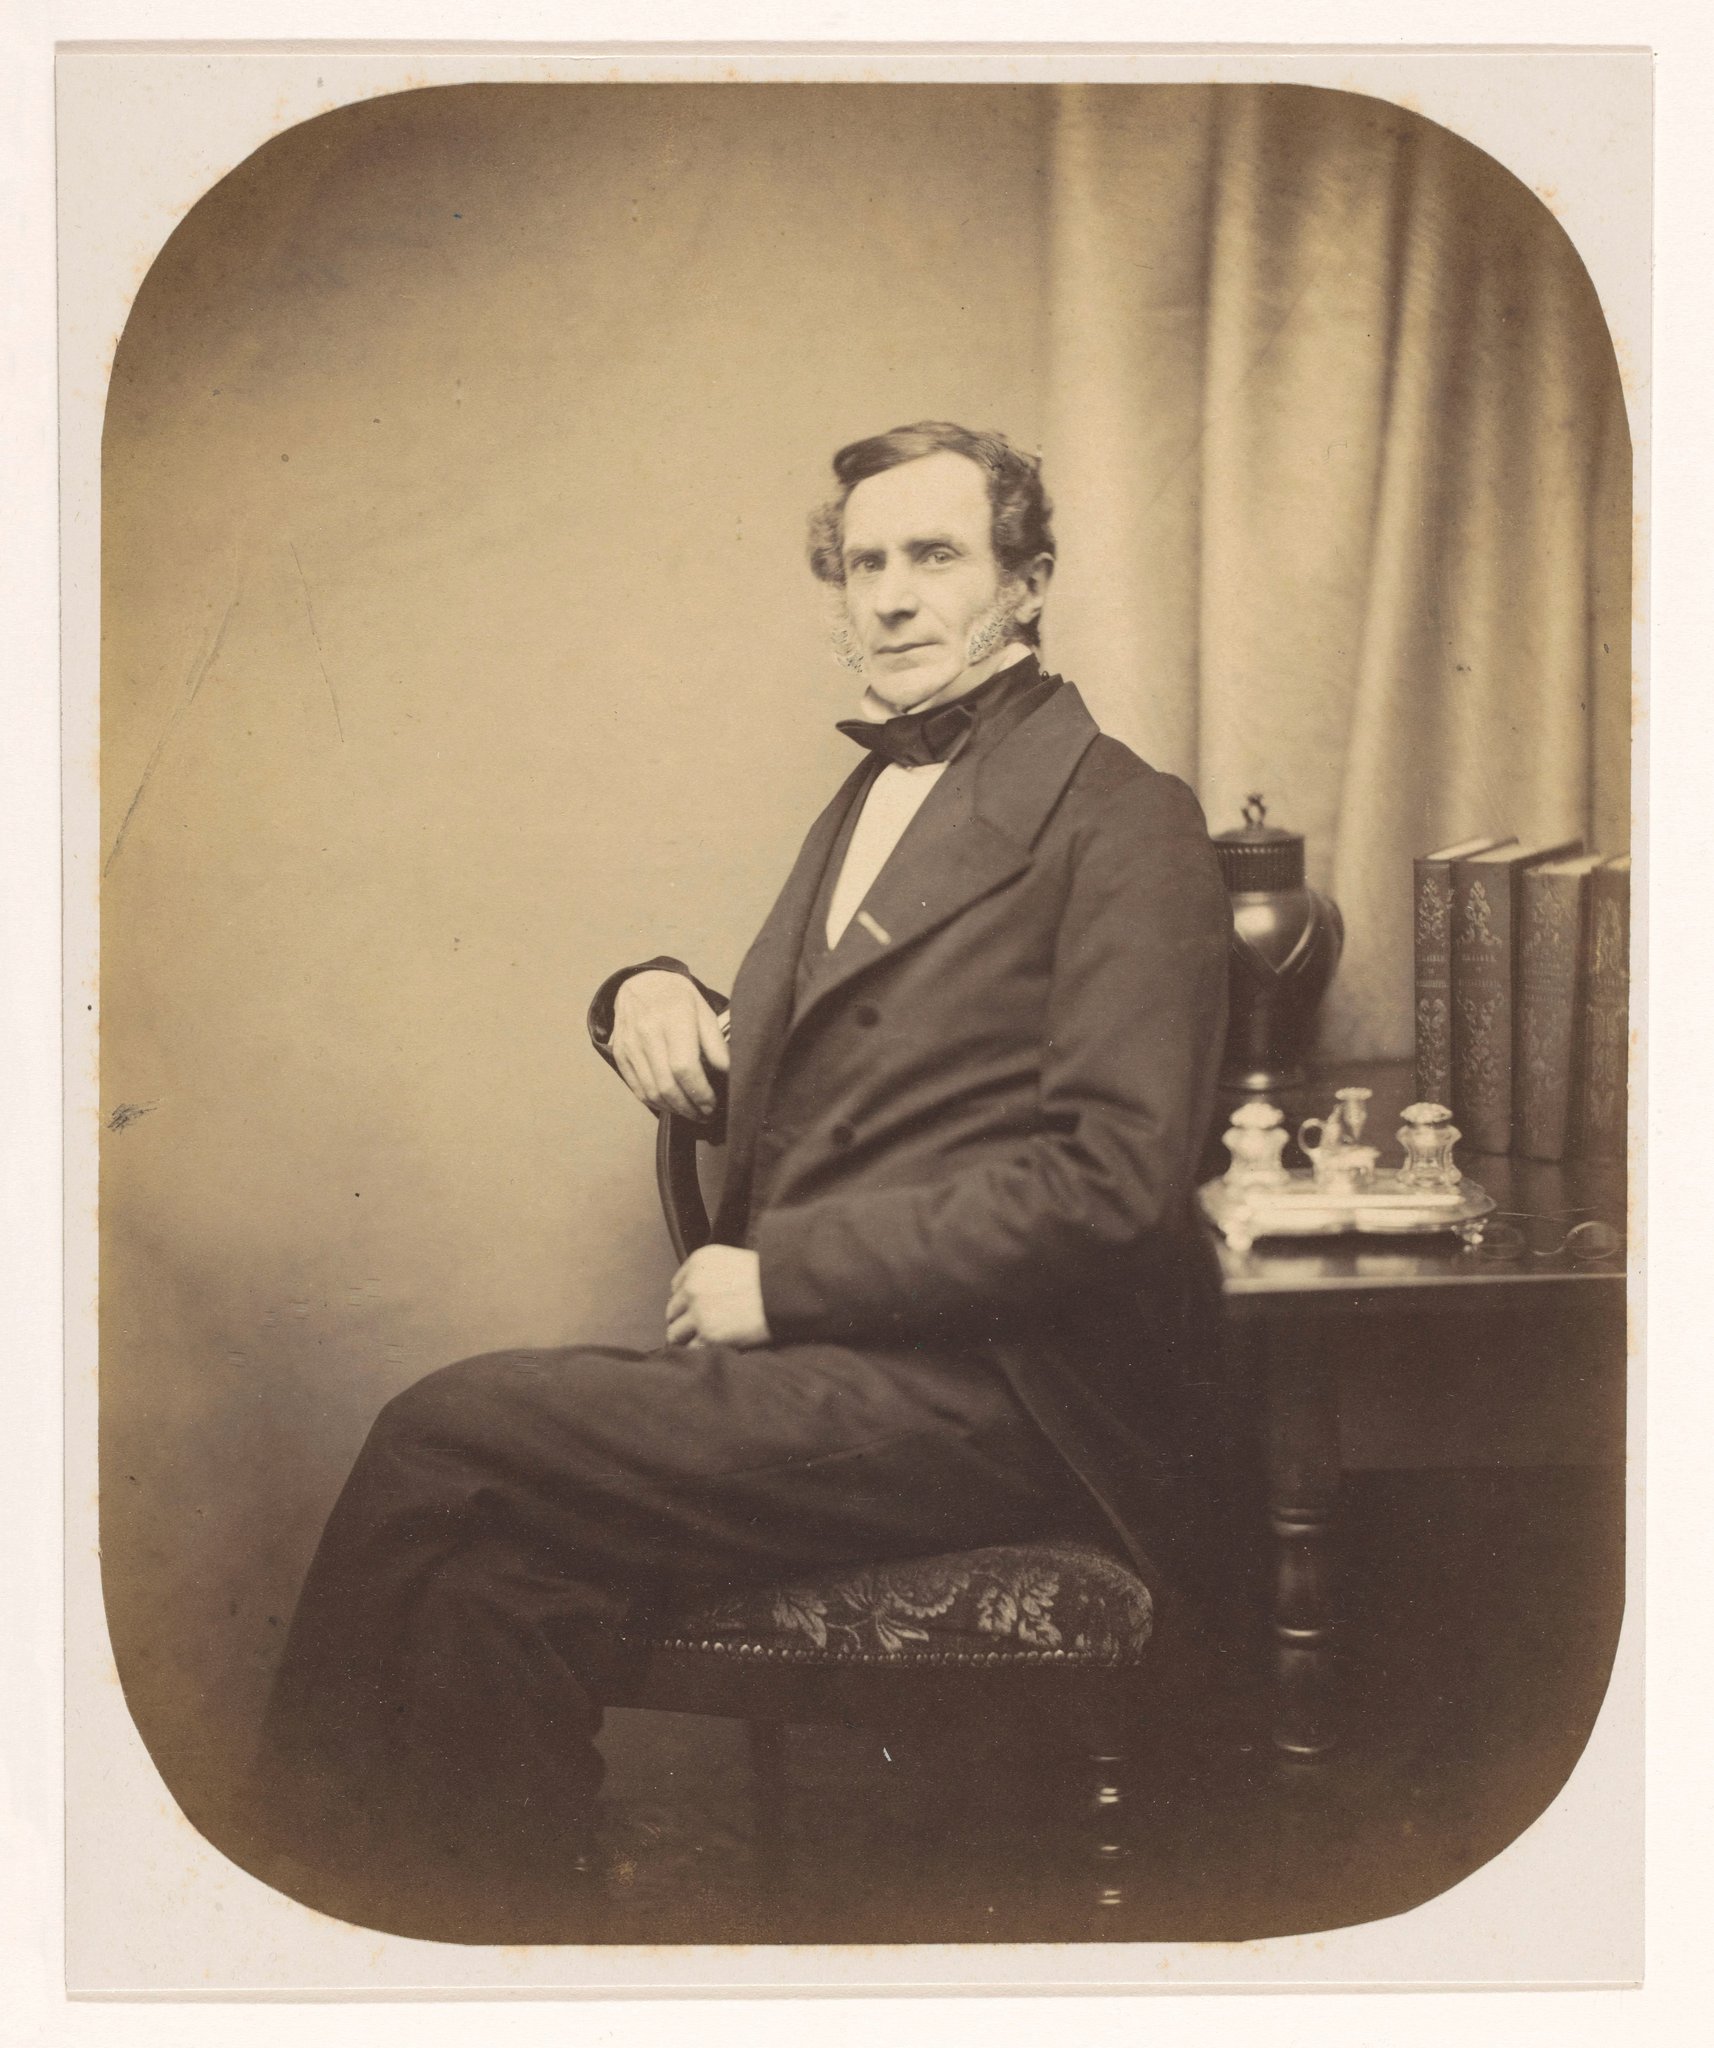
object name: photograph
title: Portret van Frederik [Friedrich] Kaiser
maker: jan goedeljee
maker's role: fotograaf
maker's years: 1824-1905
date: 1865-1872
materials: cardboard, paper, photographic support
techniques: albumen print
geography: leiden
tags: leiden, frederik kaiser, historical persons, science and technology (+ portrait of scholar, scientist)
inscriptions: label: ‘Photographie van J. Goedeljee Papengr. hoek Langebrug Leiden’